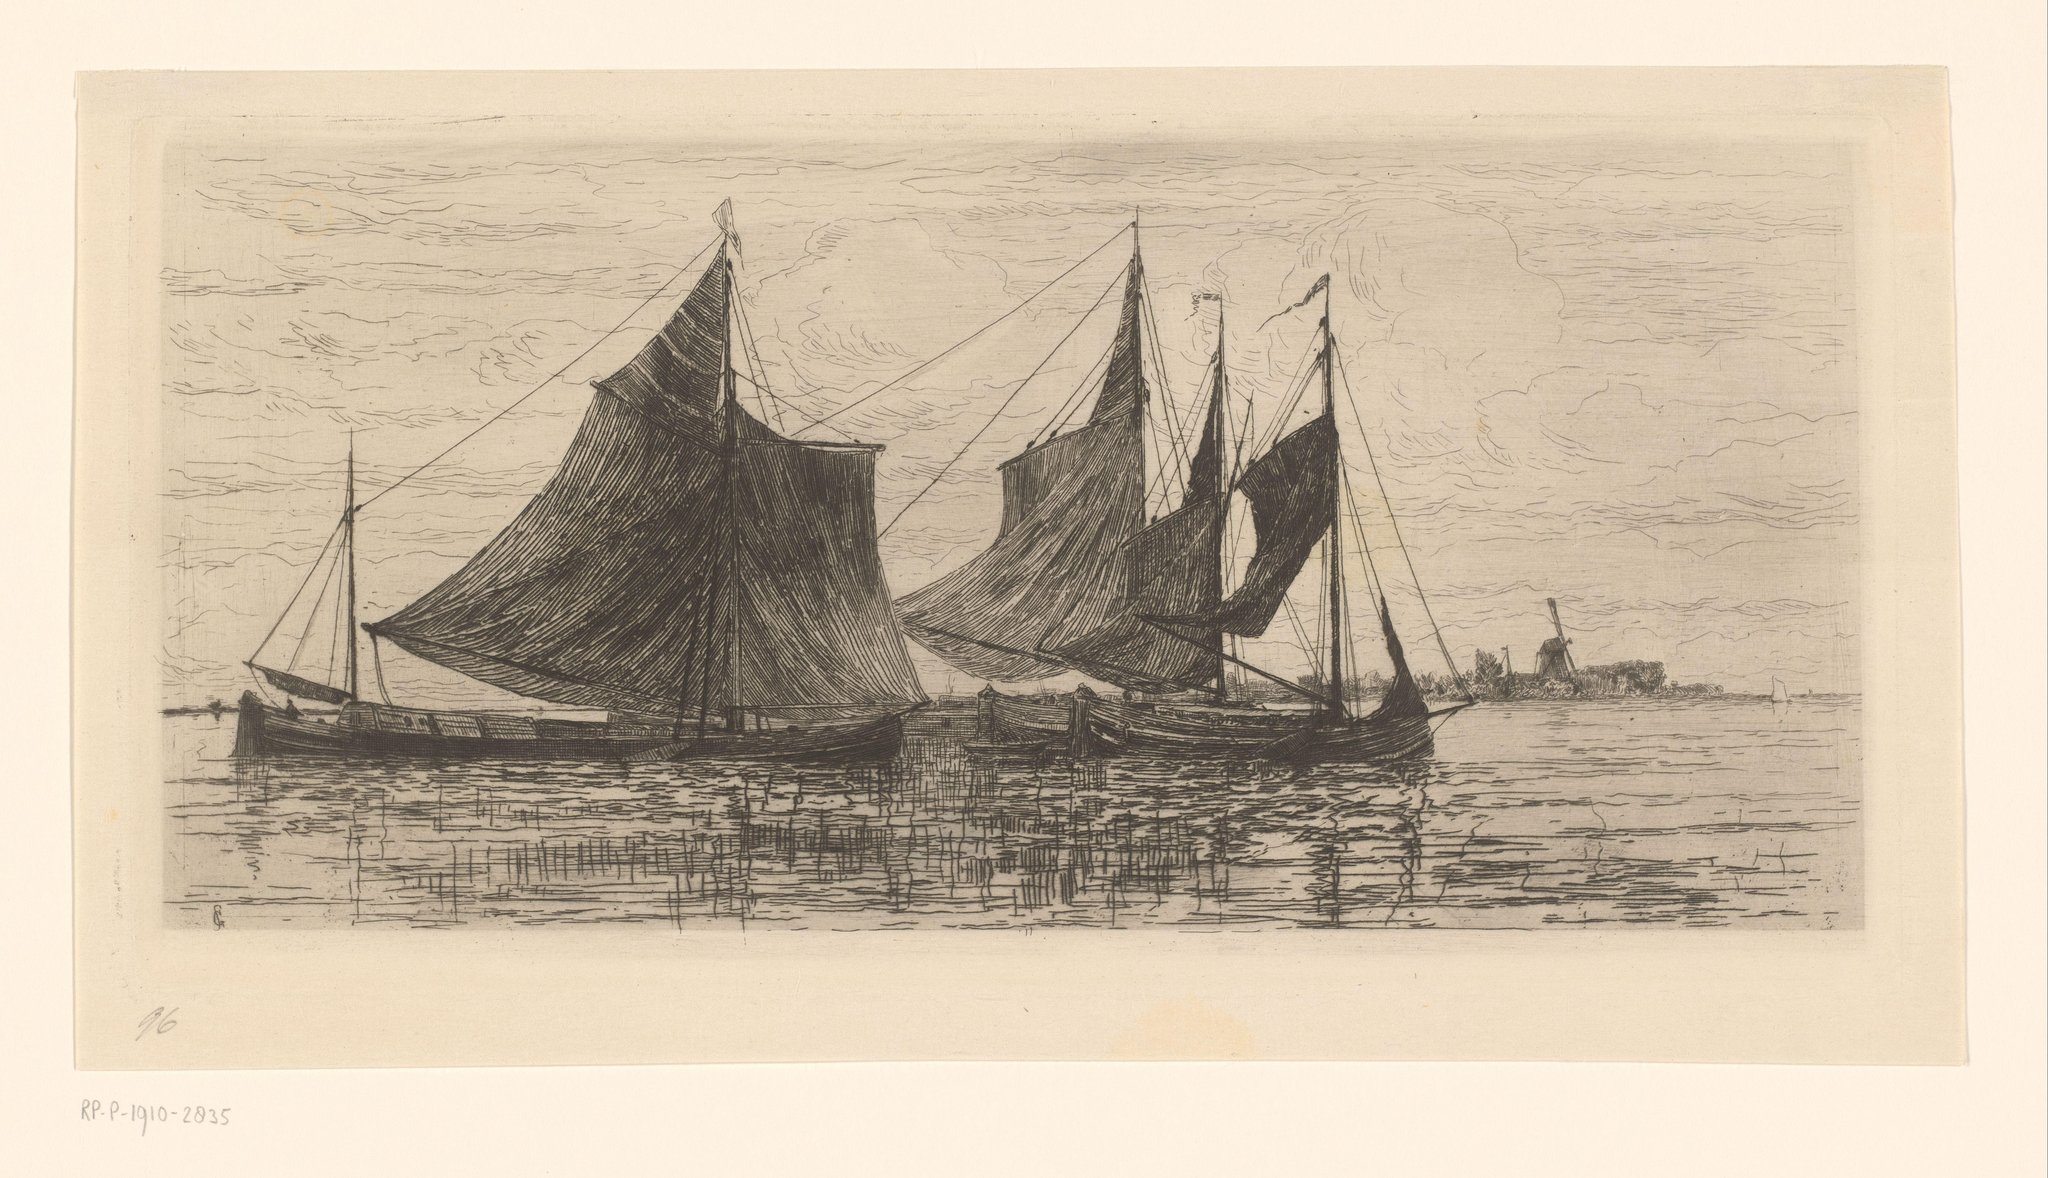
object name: print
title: La Hollande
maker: carel nicolaas storm van s-gravesande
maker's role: draughtsman, print maker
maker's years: 1841-1924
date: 1877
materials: paper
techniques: etching, intaglio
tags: sailing-ship, sailing-boat (+ arrival, coming to anchor, at anchor), dordrecht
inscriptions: collector's mark: Lugt 2228